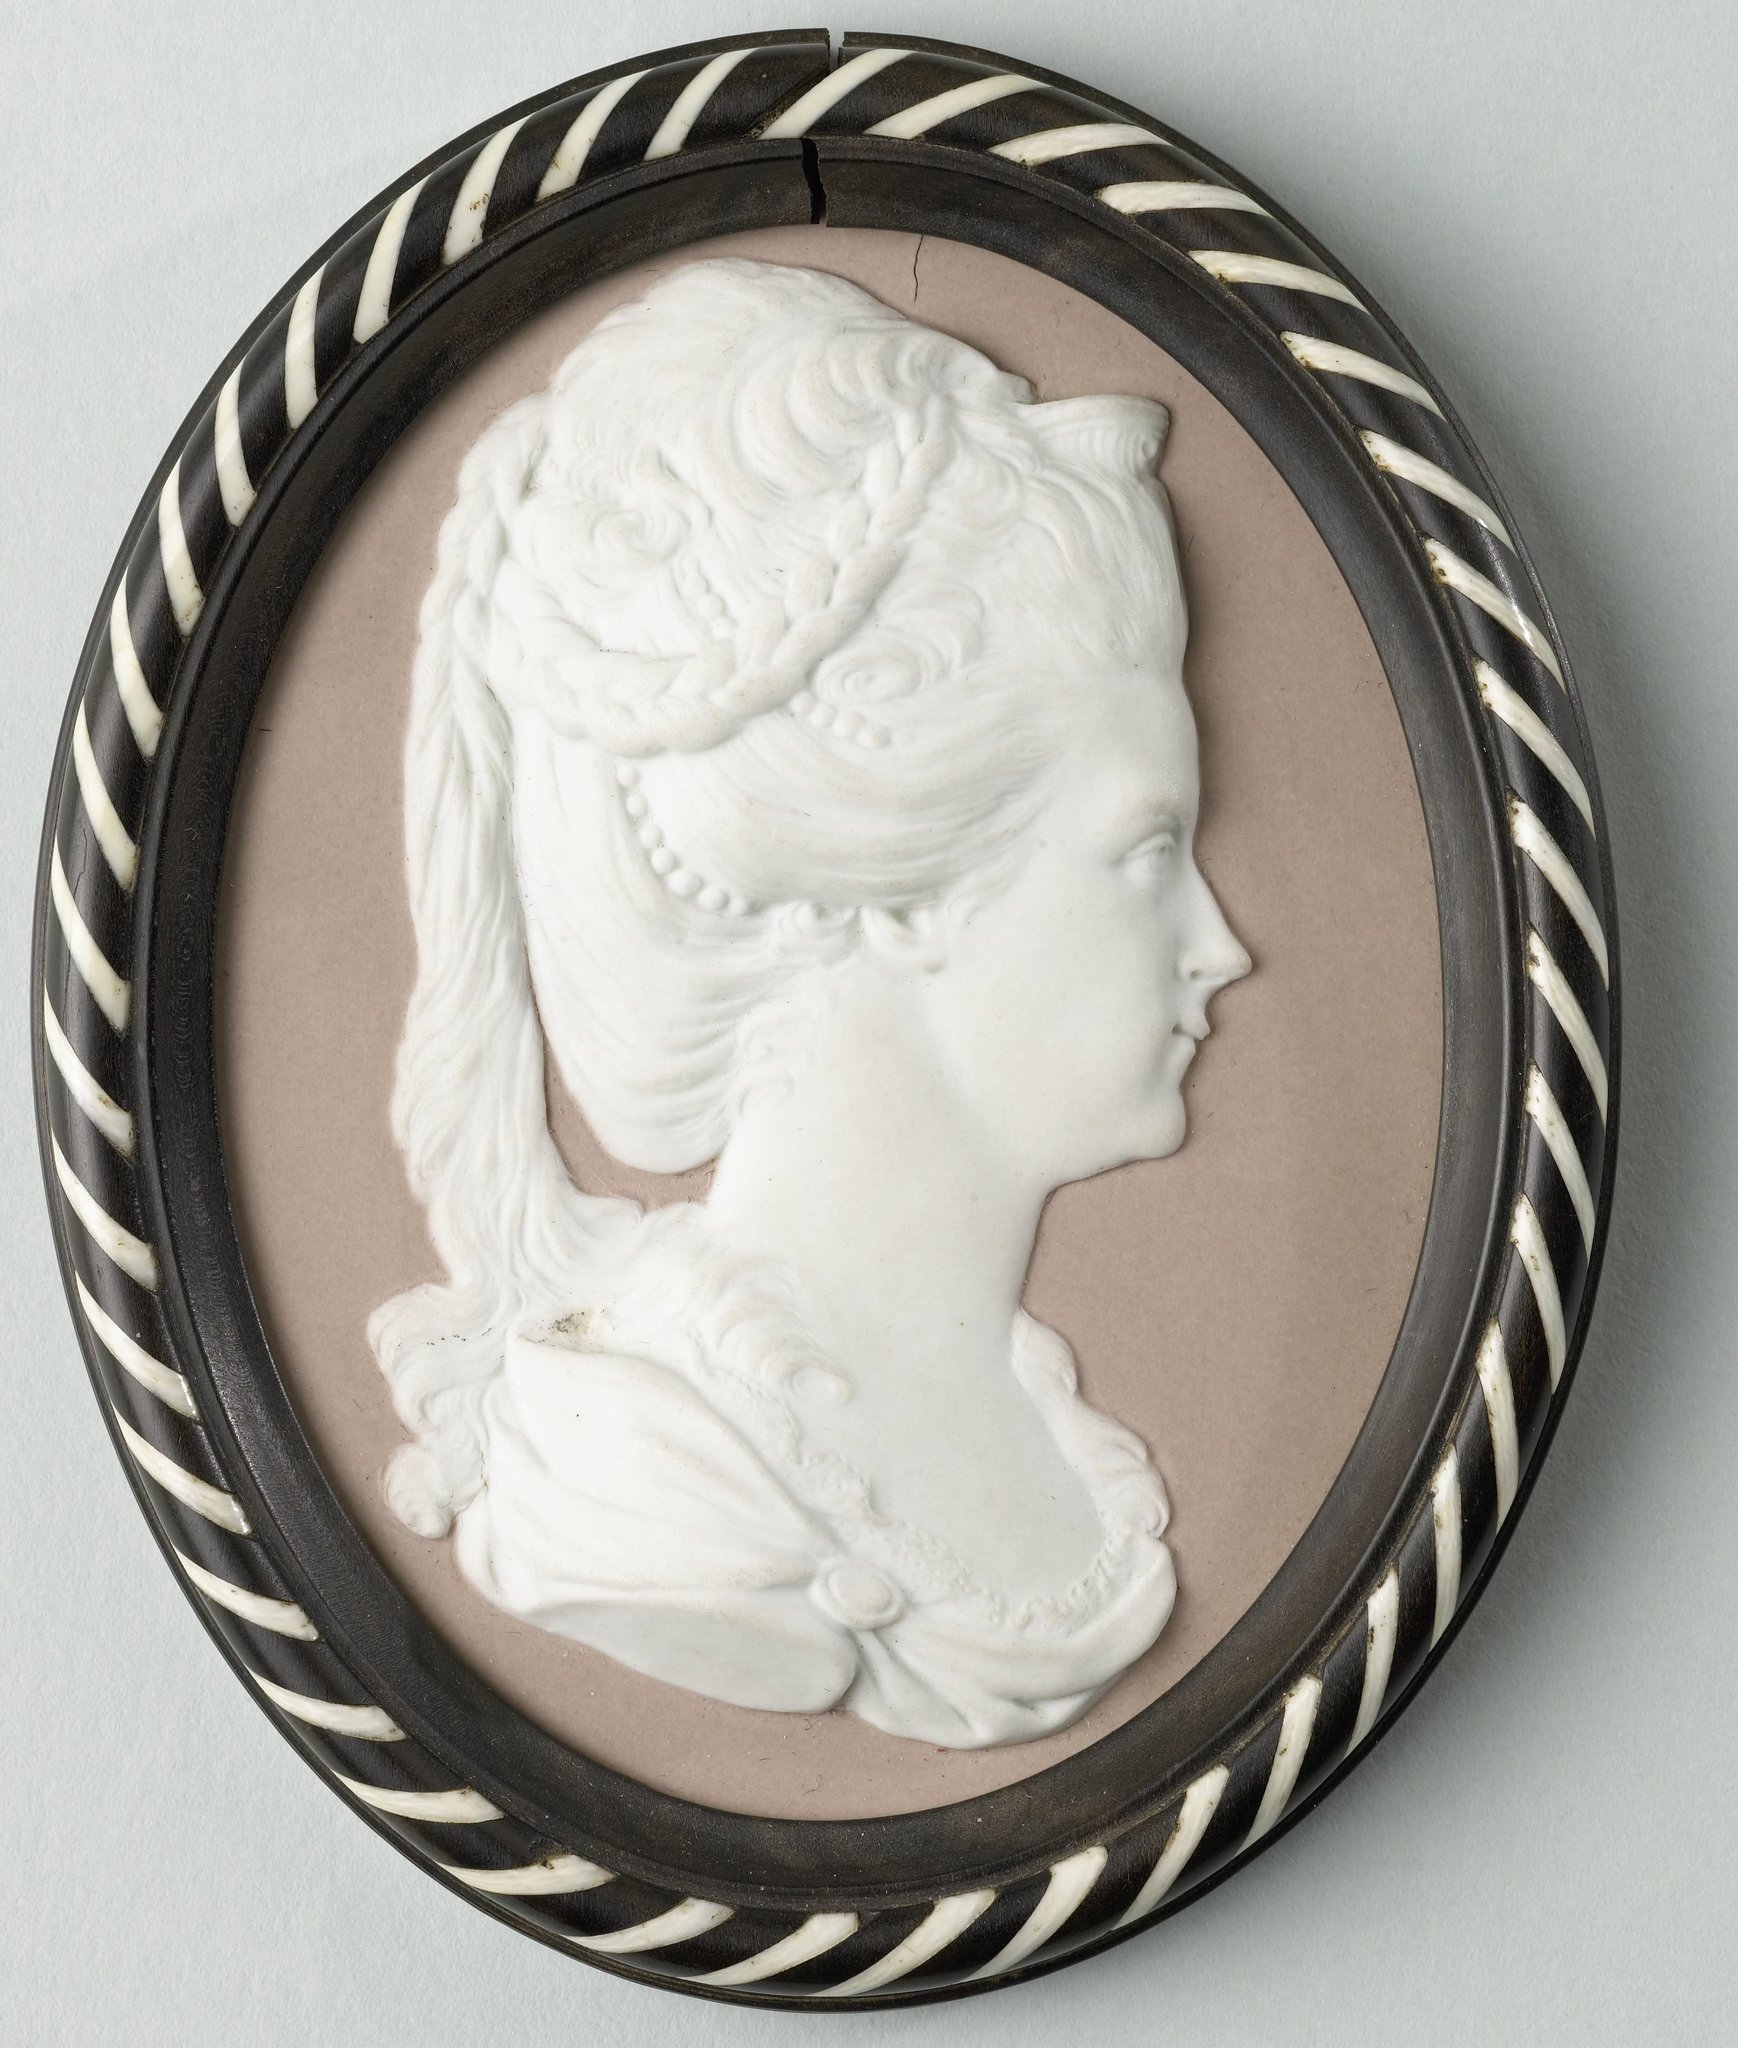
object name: portretmedaillon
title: Wilhelmina van Pruisen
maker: johann heinrich schepp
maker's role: sculptor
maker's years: 1736-1811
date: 1782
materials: bone, wood, porcelain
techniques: cutting, firing, inlay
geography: england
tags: berlin, painter, draughtsman, wilhelmina of prussia (princess of orange), historical persons - bb - woman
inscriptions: inscription: ‘WEDGEWOOD’